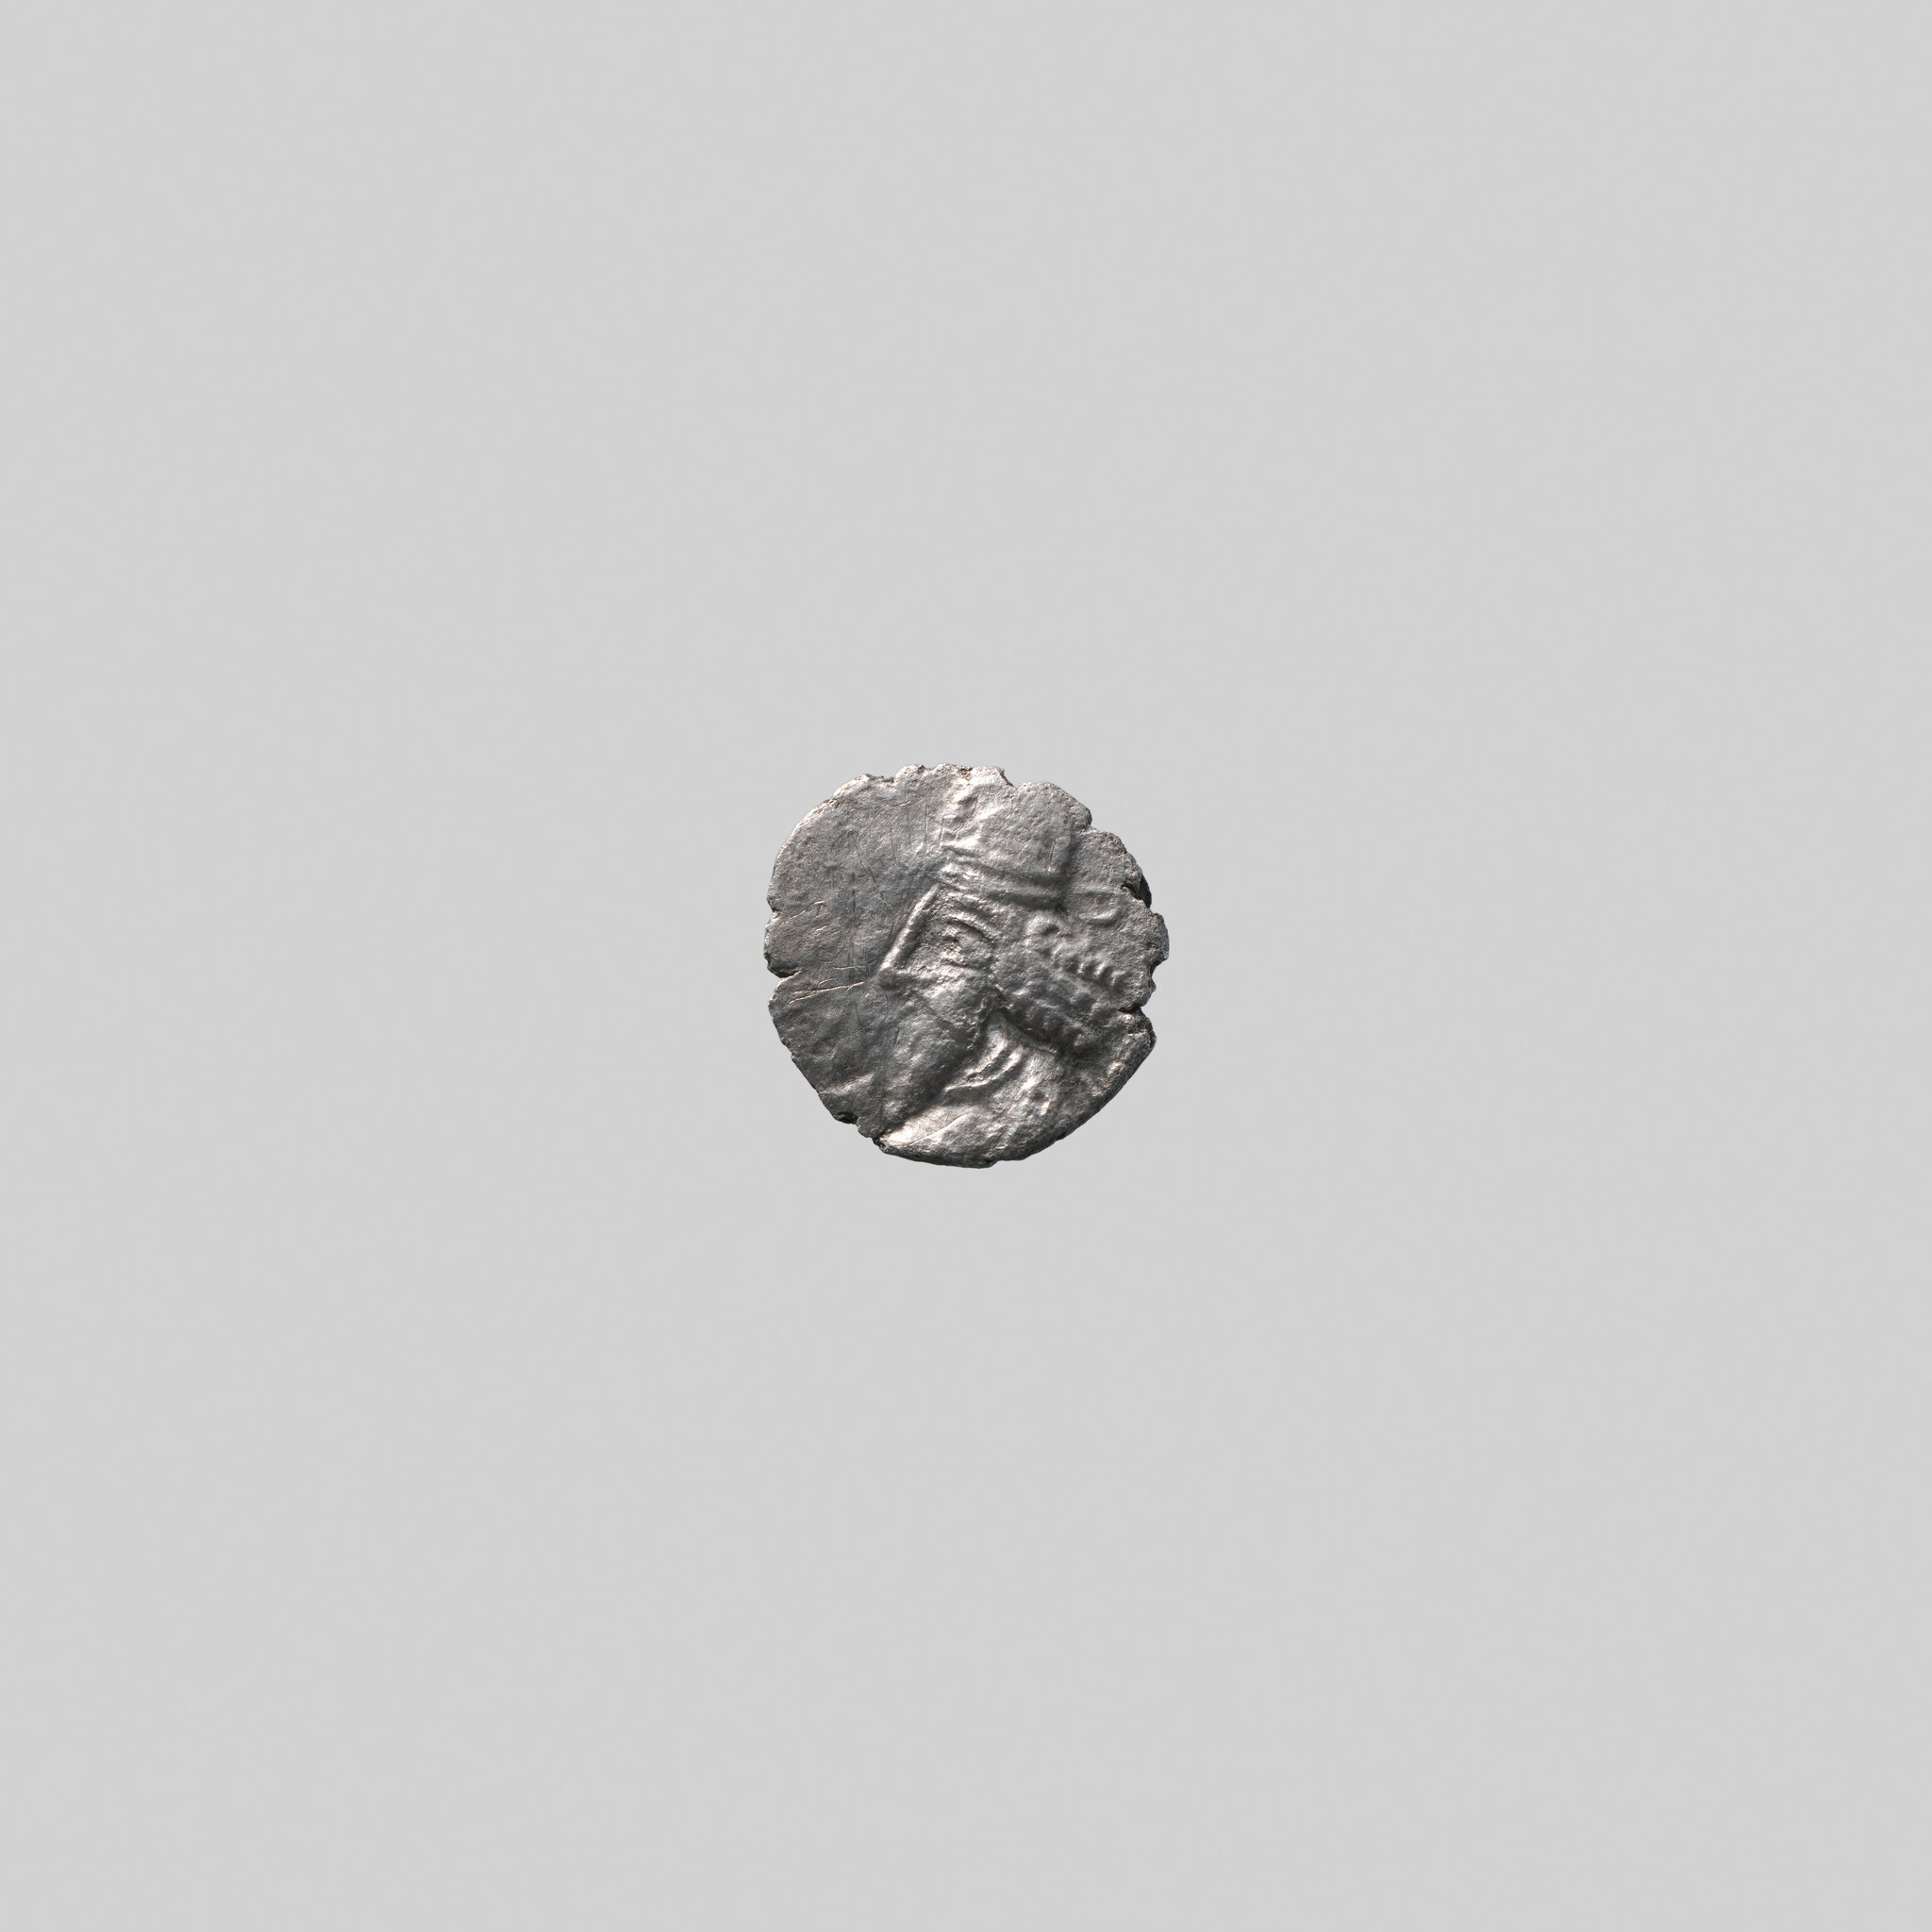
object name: coin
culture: parthian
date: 50-100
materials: silver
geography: iran